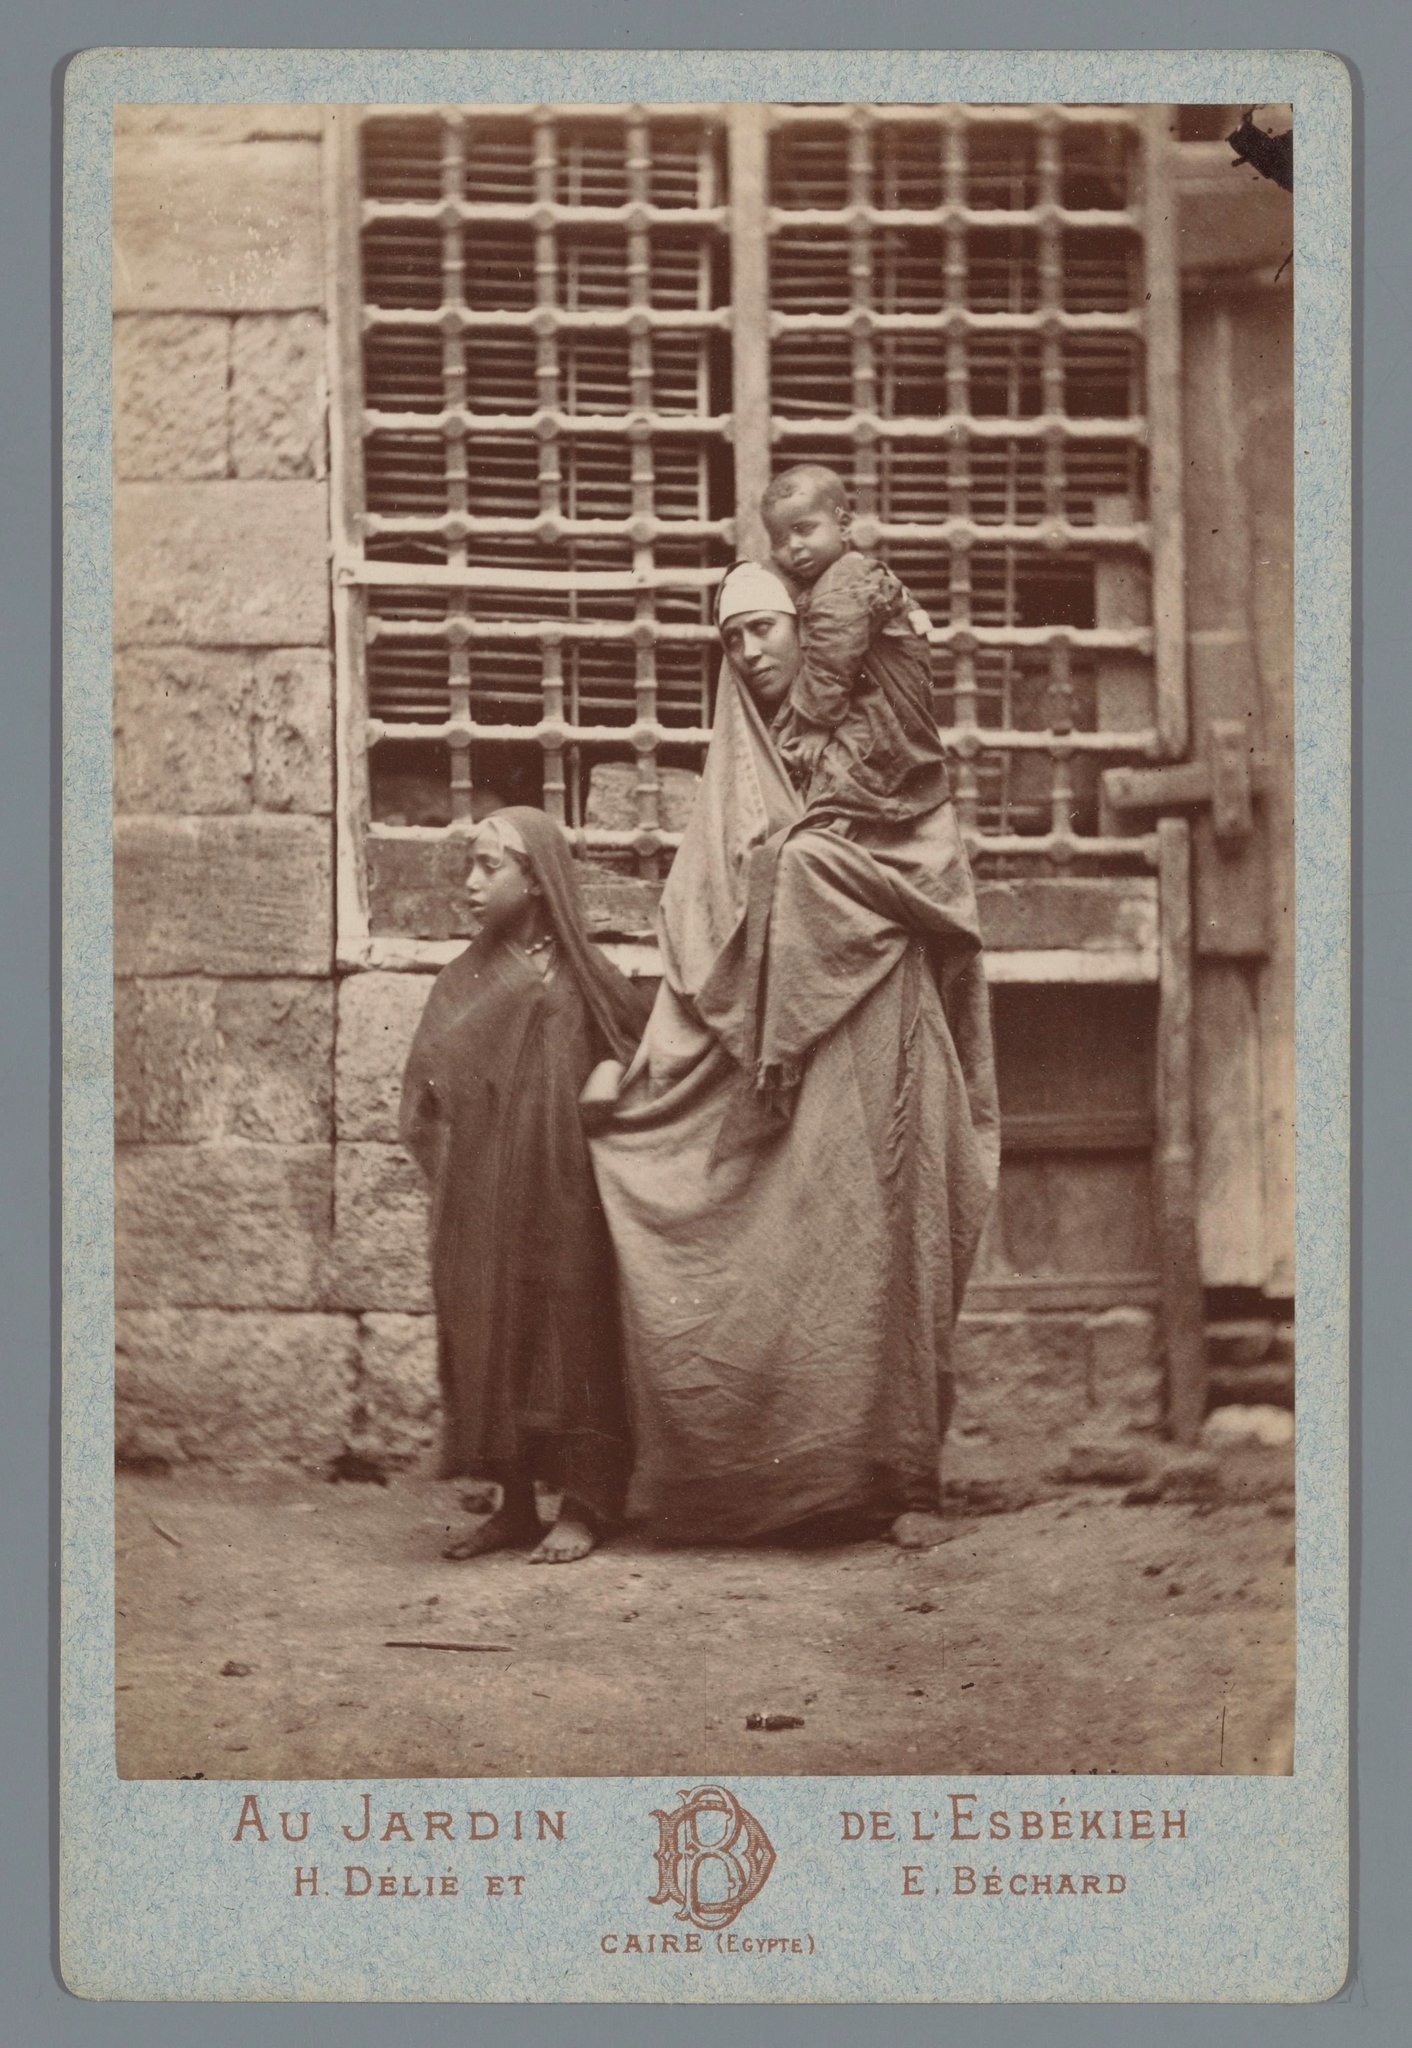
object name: cabinet photograph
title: Vrouw met kinderen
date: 1869-1890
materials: cardboard, photographic support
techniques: albumen print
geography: egypt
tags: adult woman, child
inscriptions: inscription: ‘Au Jardin/ de l'Esbékieh/ H. Délié & E. Béchard/ Caire/ Egypte/ Les Clichés Sont Conservés.’